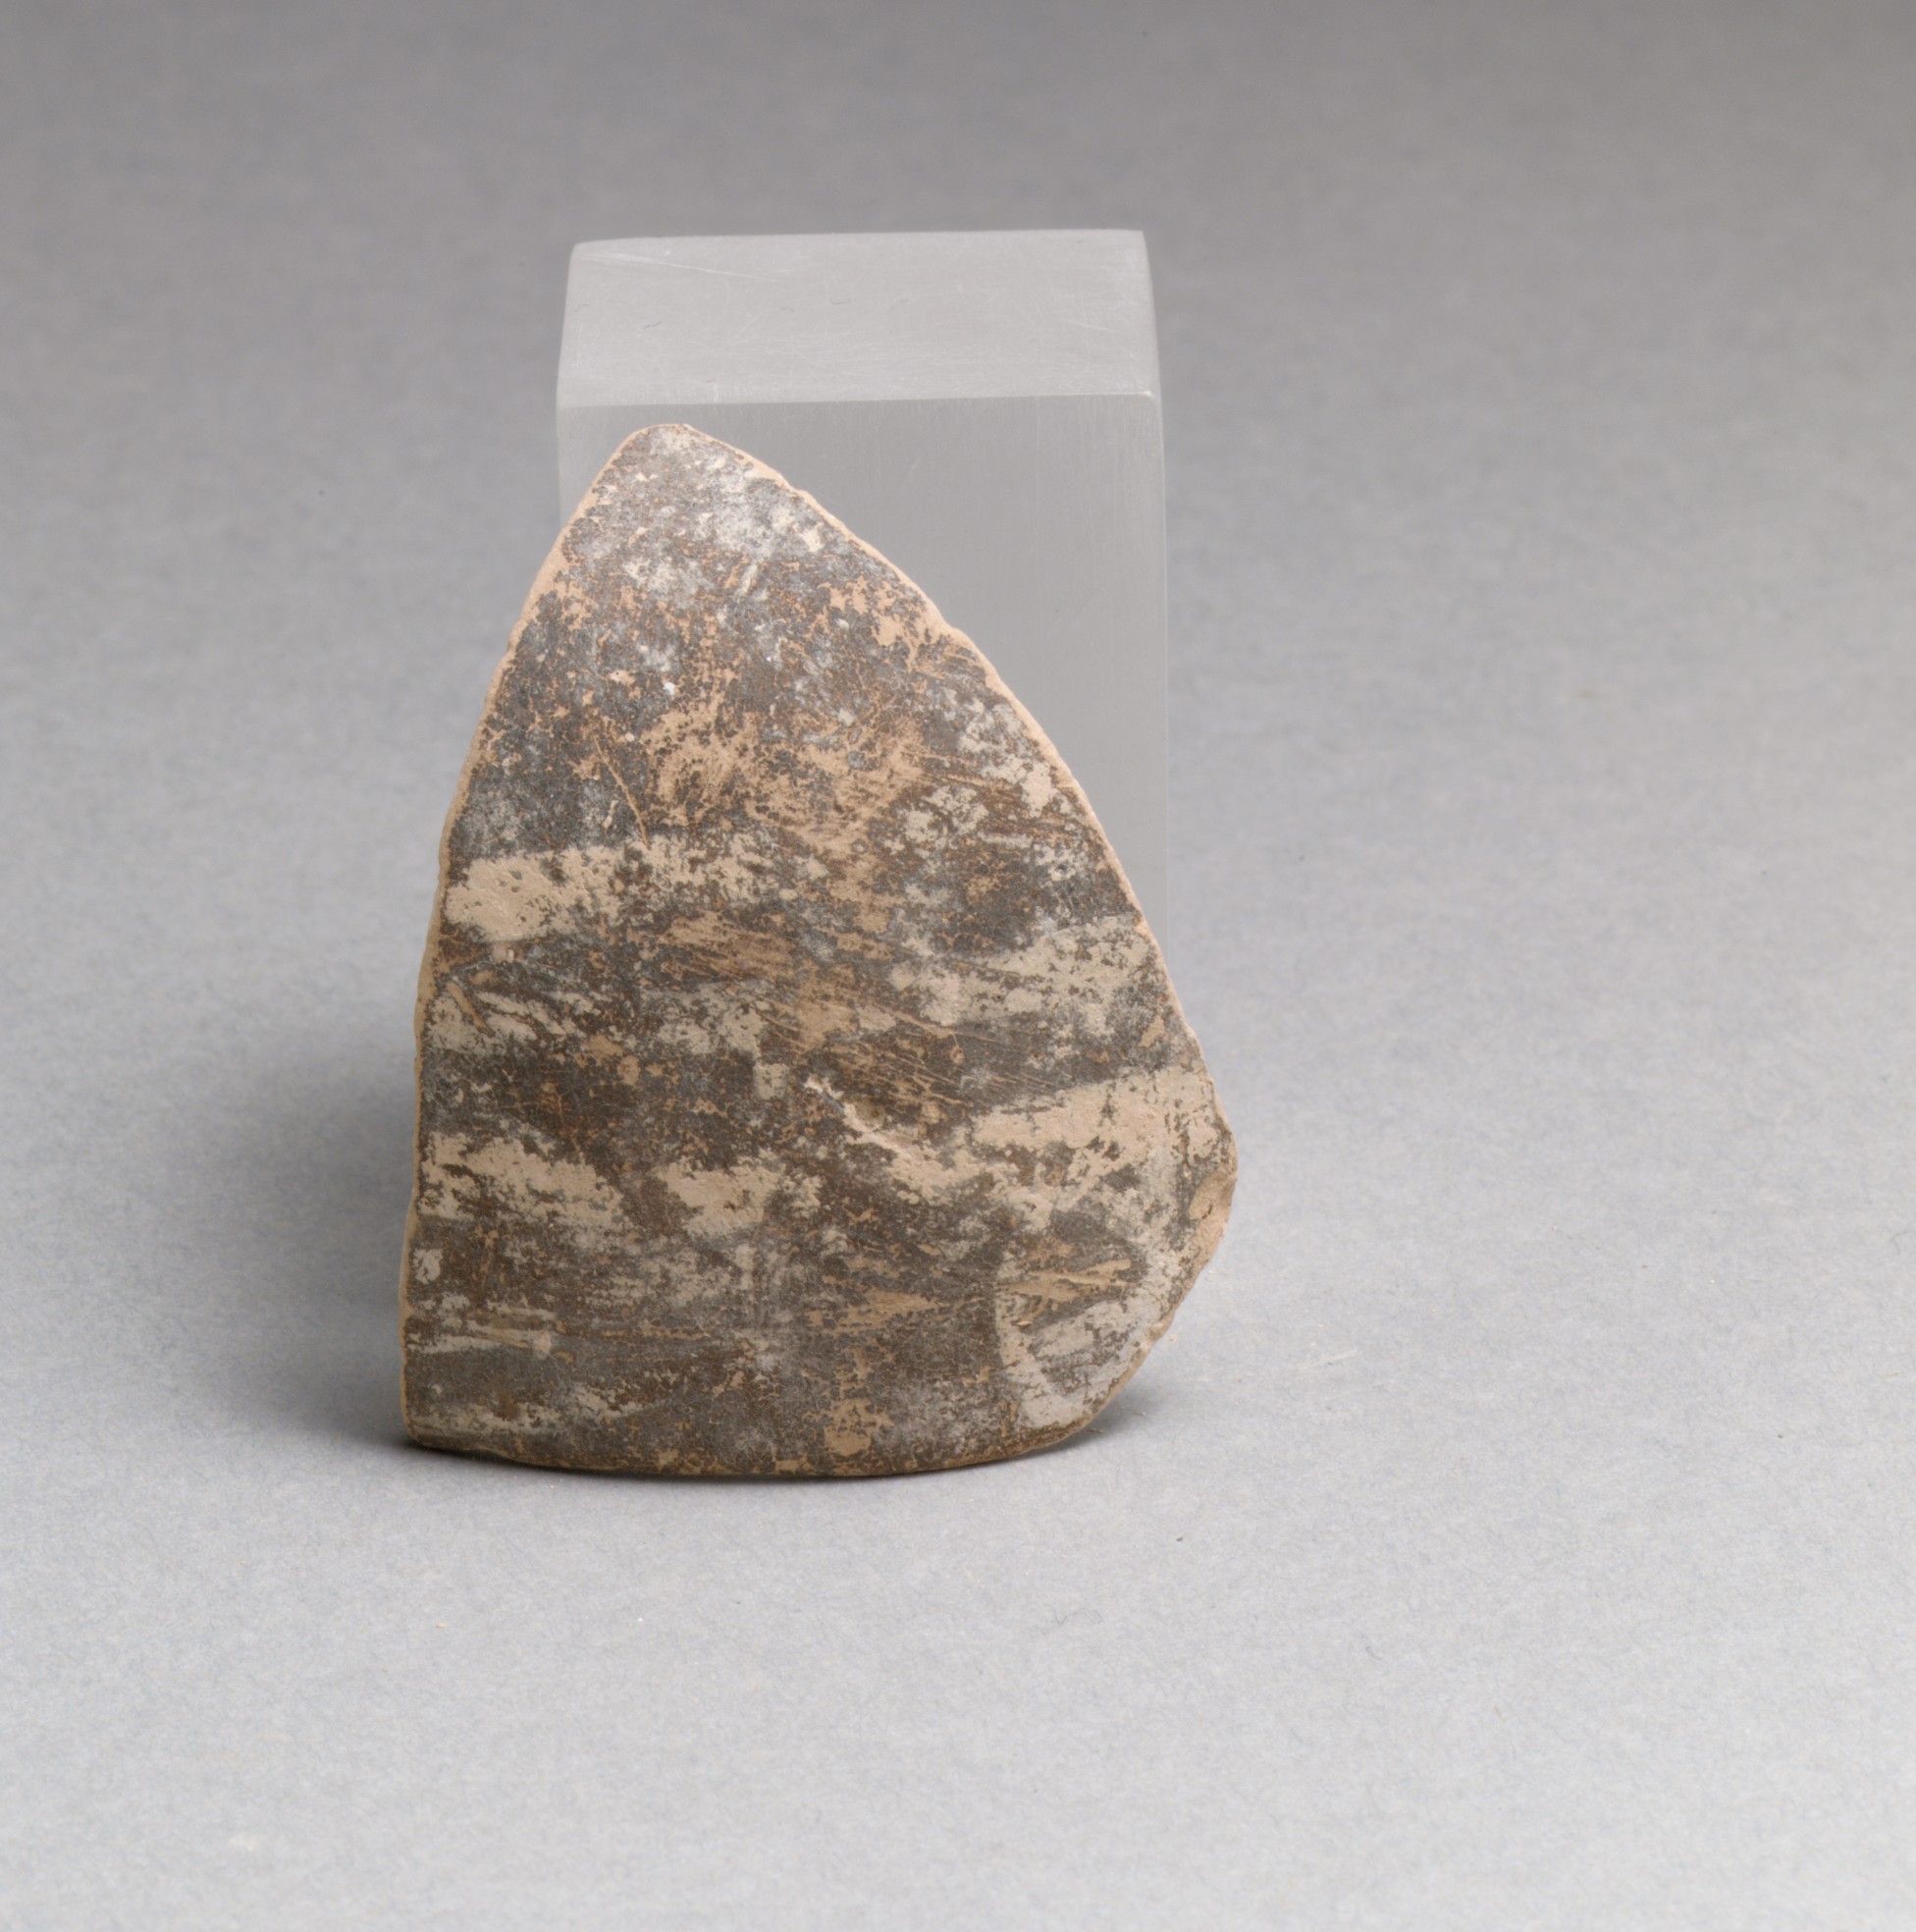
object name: vase fragment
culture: minoan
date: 2600-2000 BCE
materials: terracotta